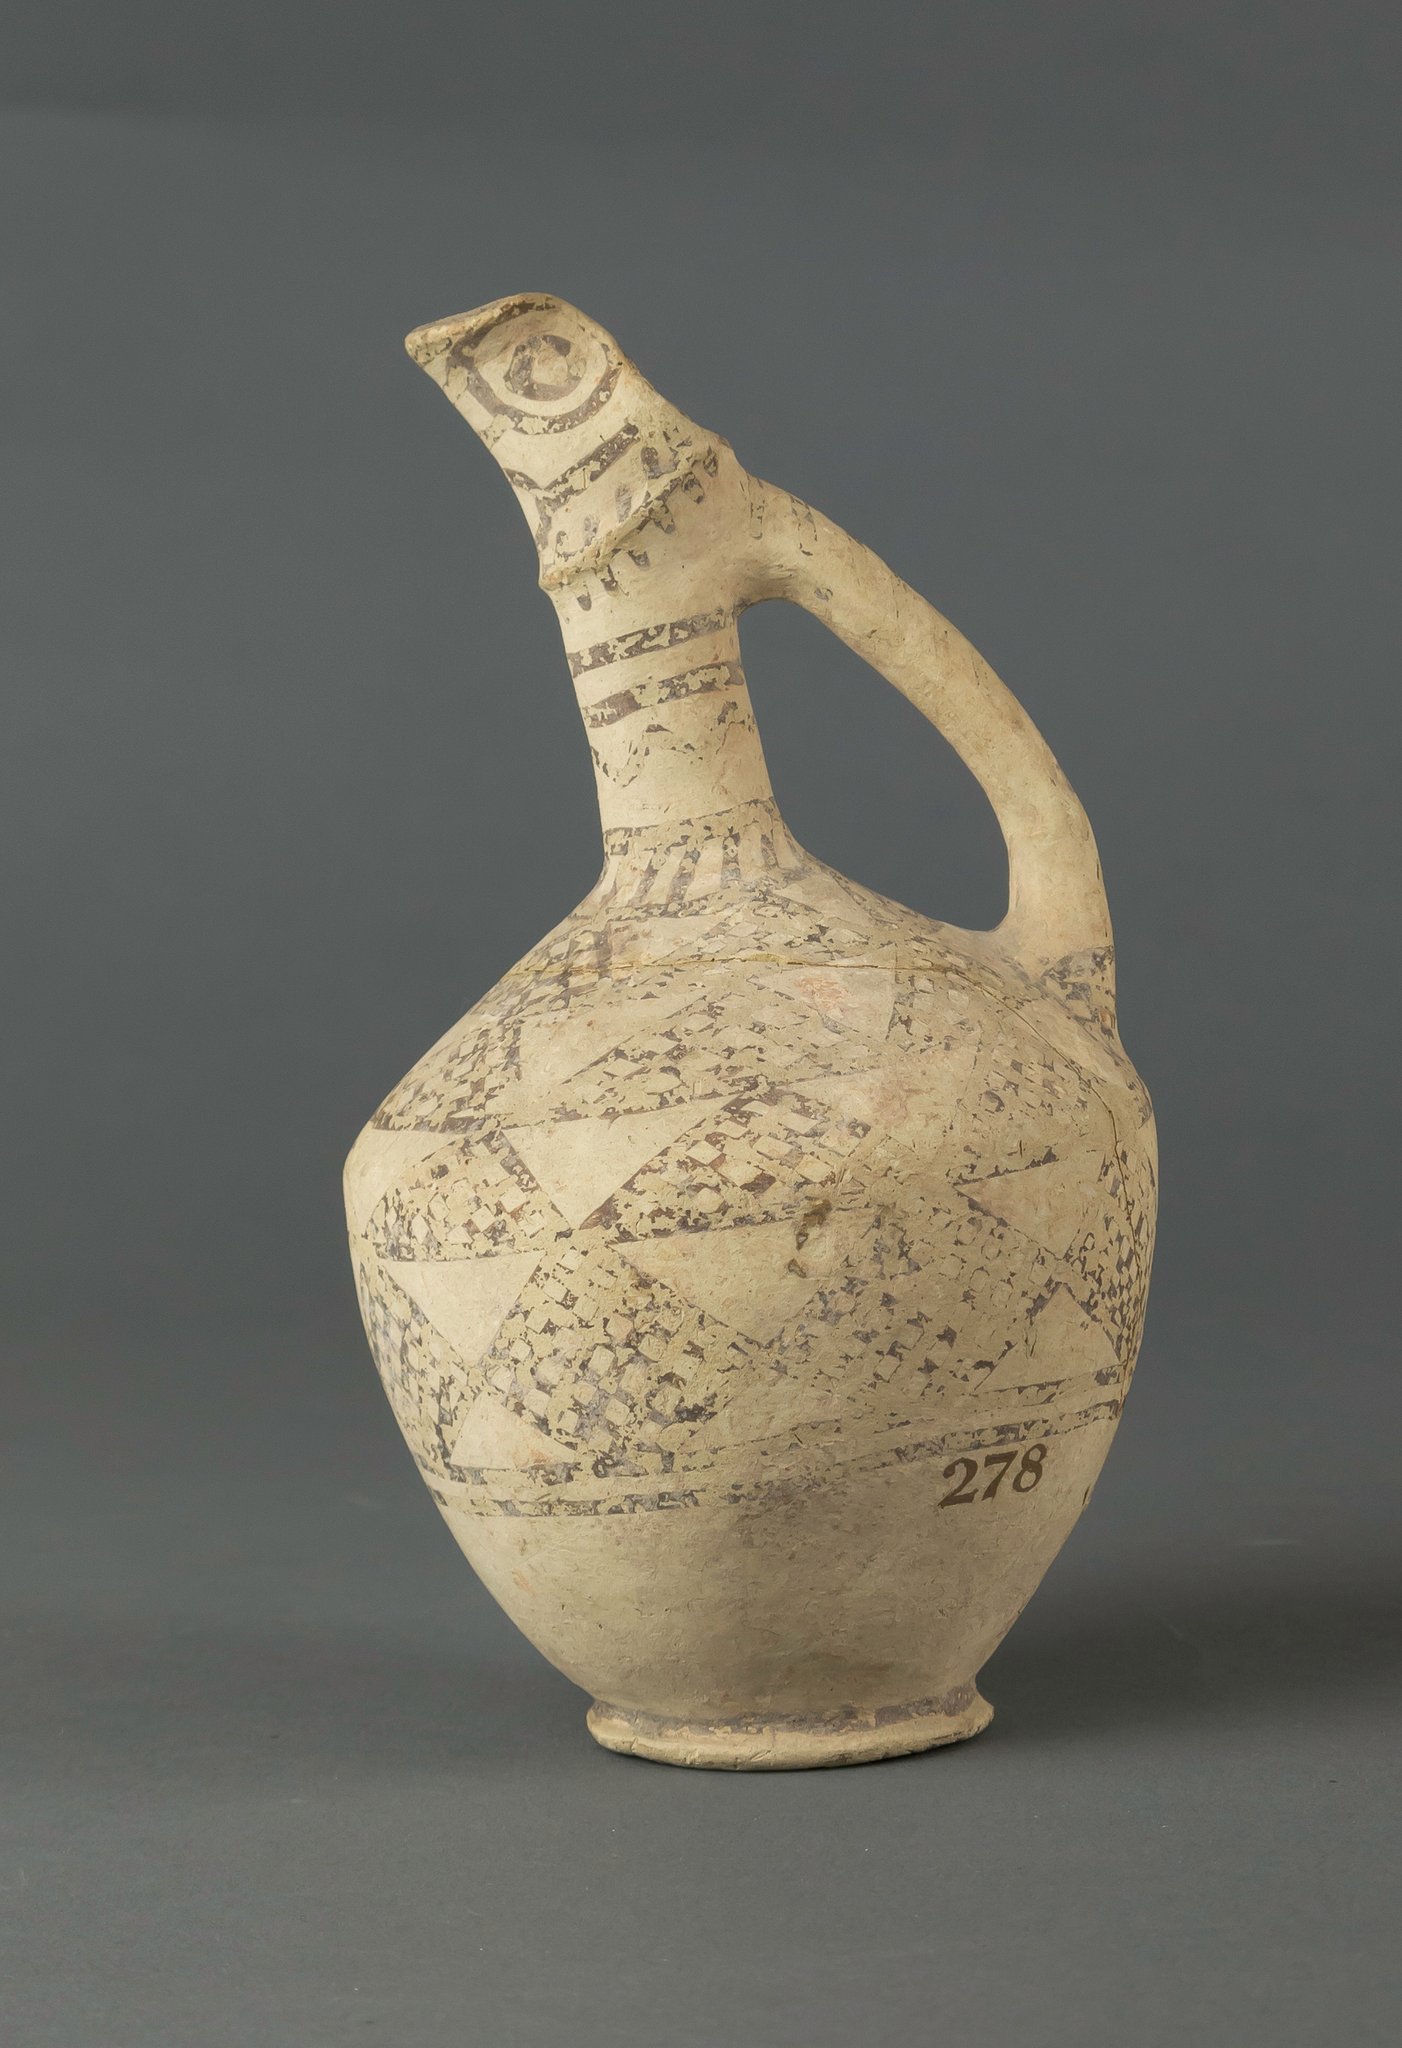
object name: jug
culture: cypriot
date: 1900-1600 BCE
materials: terracotta